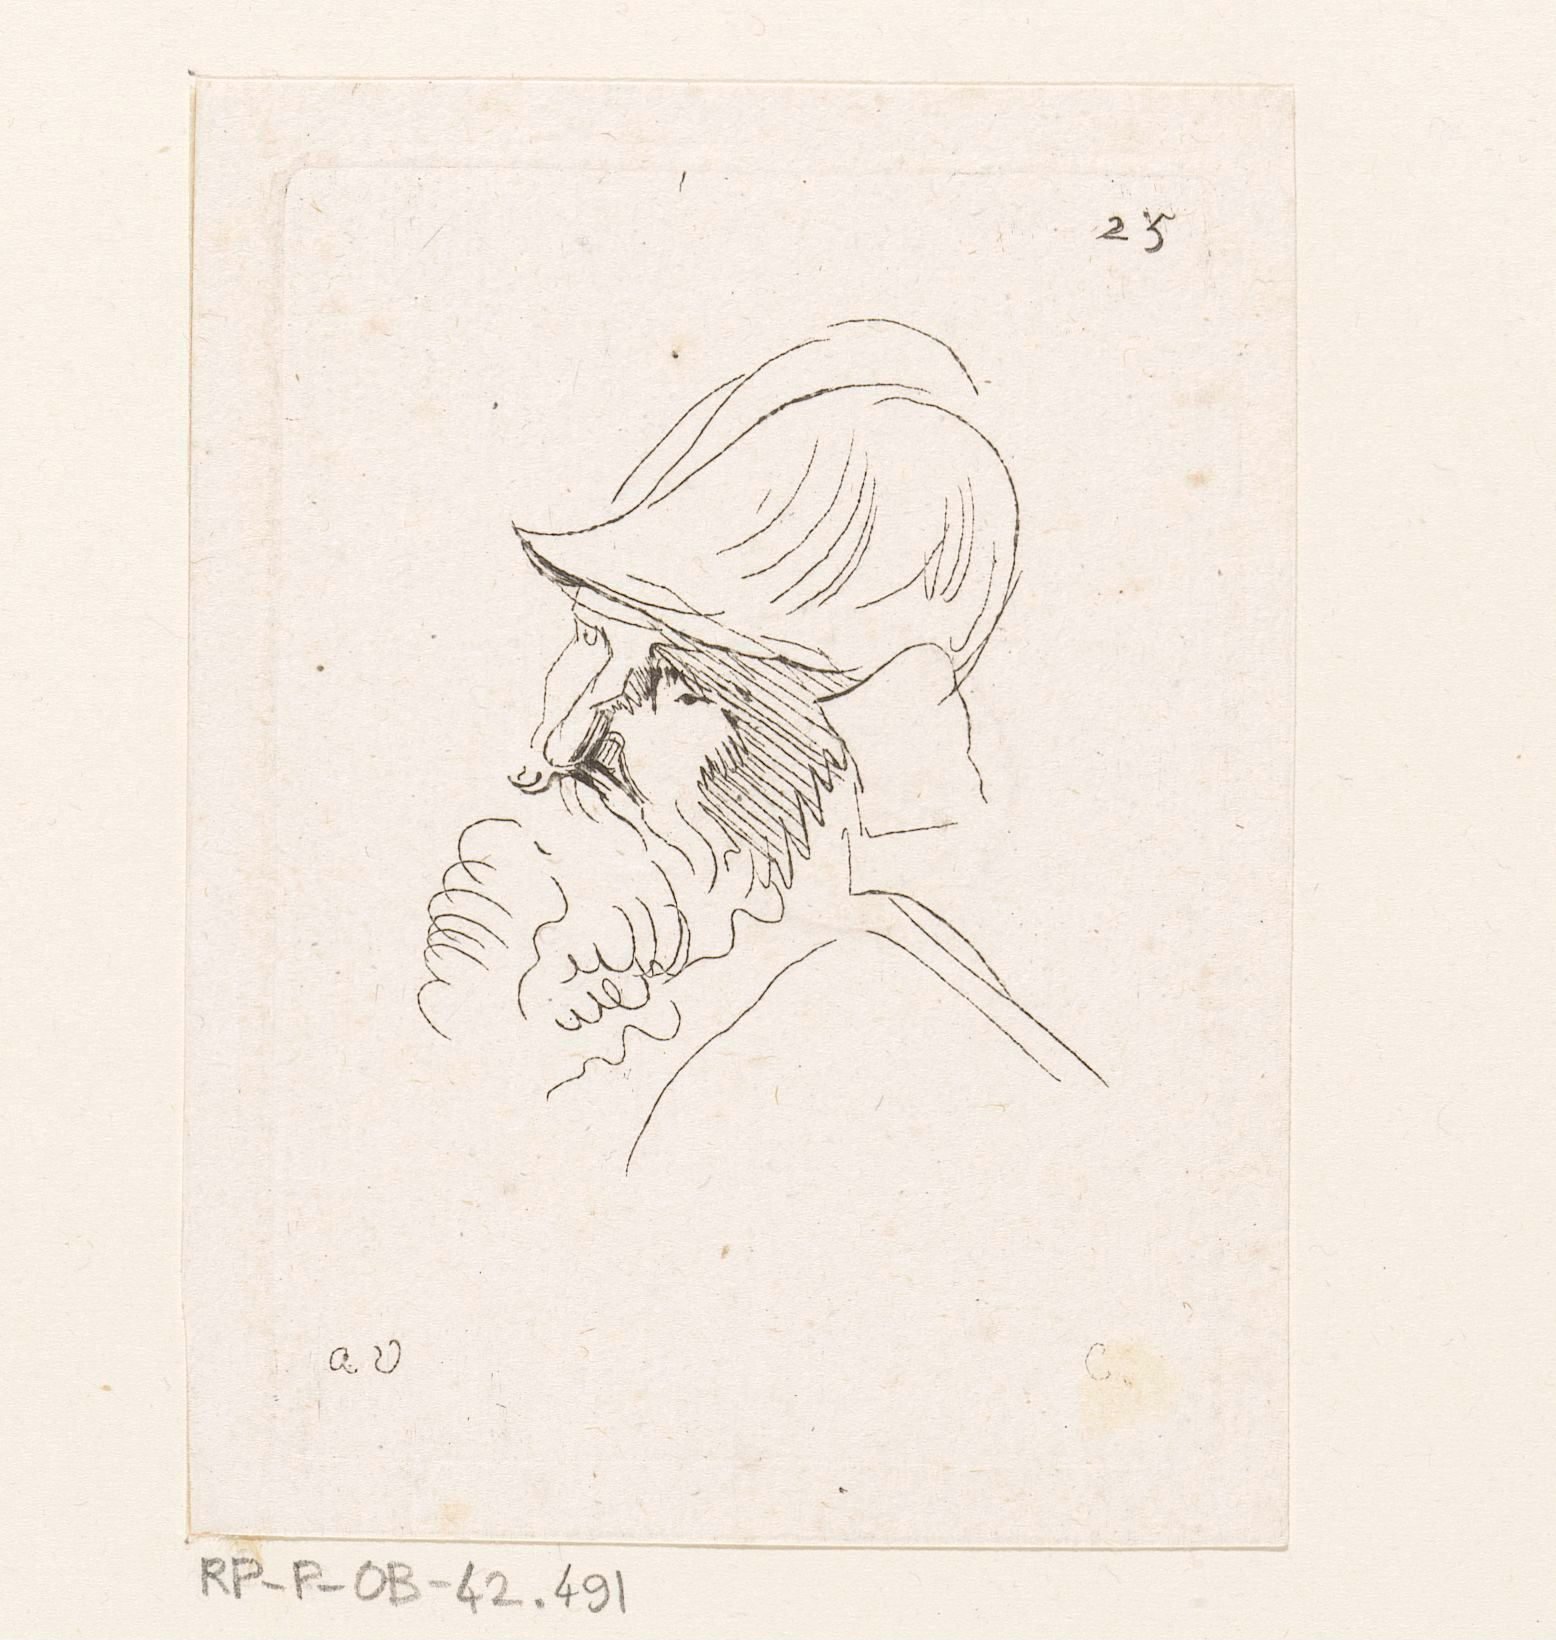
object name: print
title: Hoofd van een man met een helm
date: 1735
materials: paper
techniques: etching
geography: france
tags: helmet, head (human), adult man, beard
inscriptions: collector's mark: Lugt 240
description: Prent uit een serie van 31 prenten naar getekende hoofden door Van Dyck, plus een titelprent naar Bouchardon, getiteld: "Recueil de Testes d'Antoine Van Dyck tirées du Cabinet de M. Crozat et gravées par M. le C. de C.".